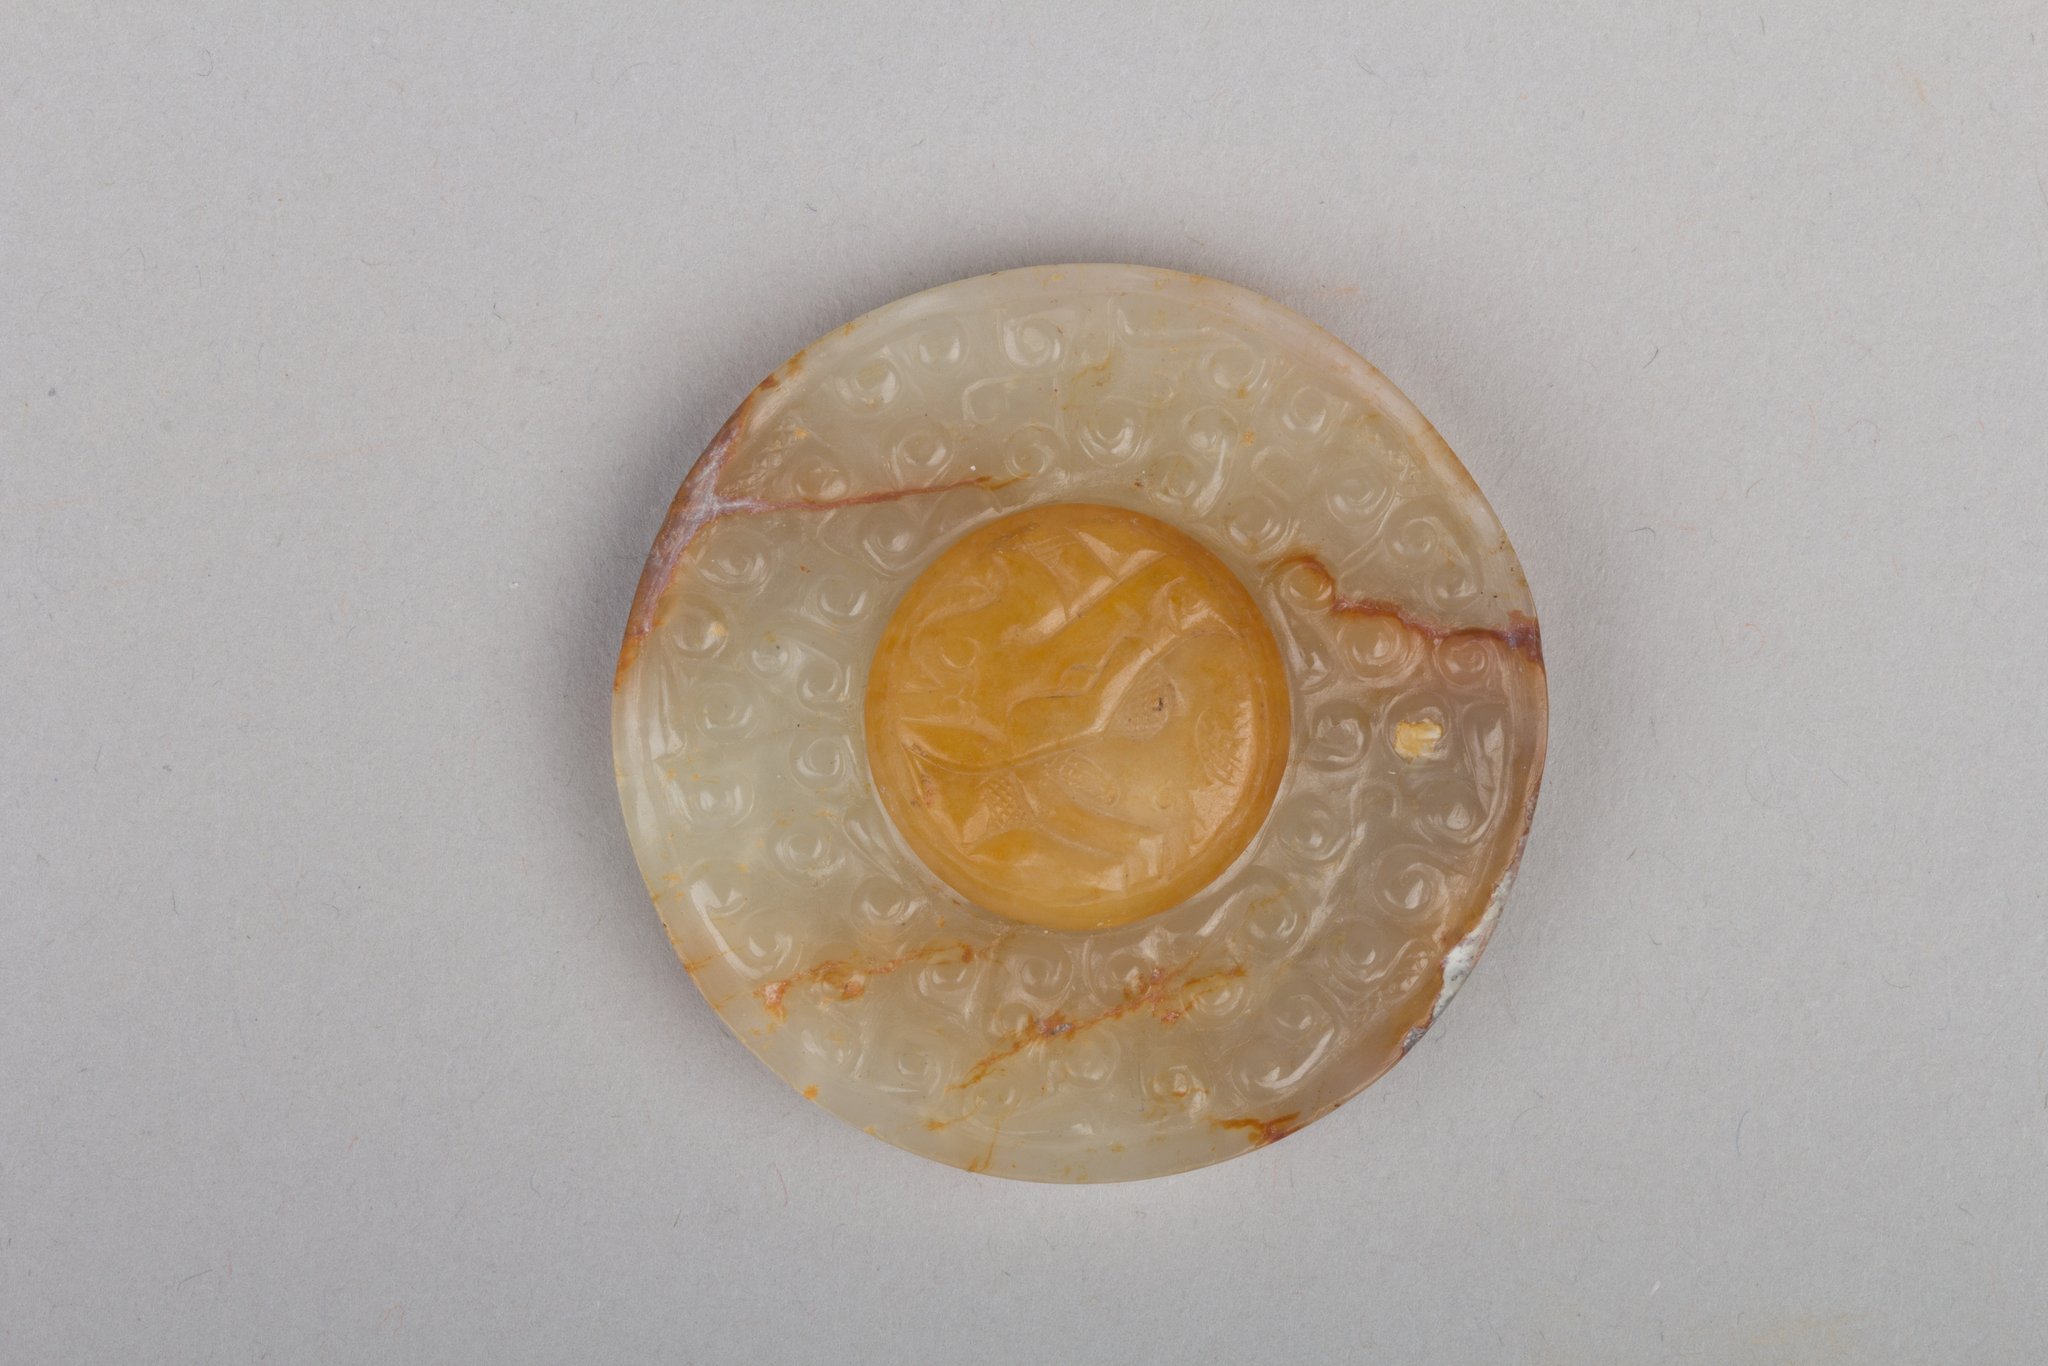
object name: ring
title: Ring with Insert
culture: chinese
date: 500-201 BCE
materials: jade